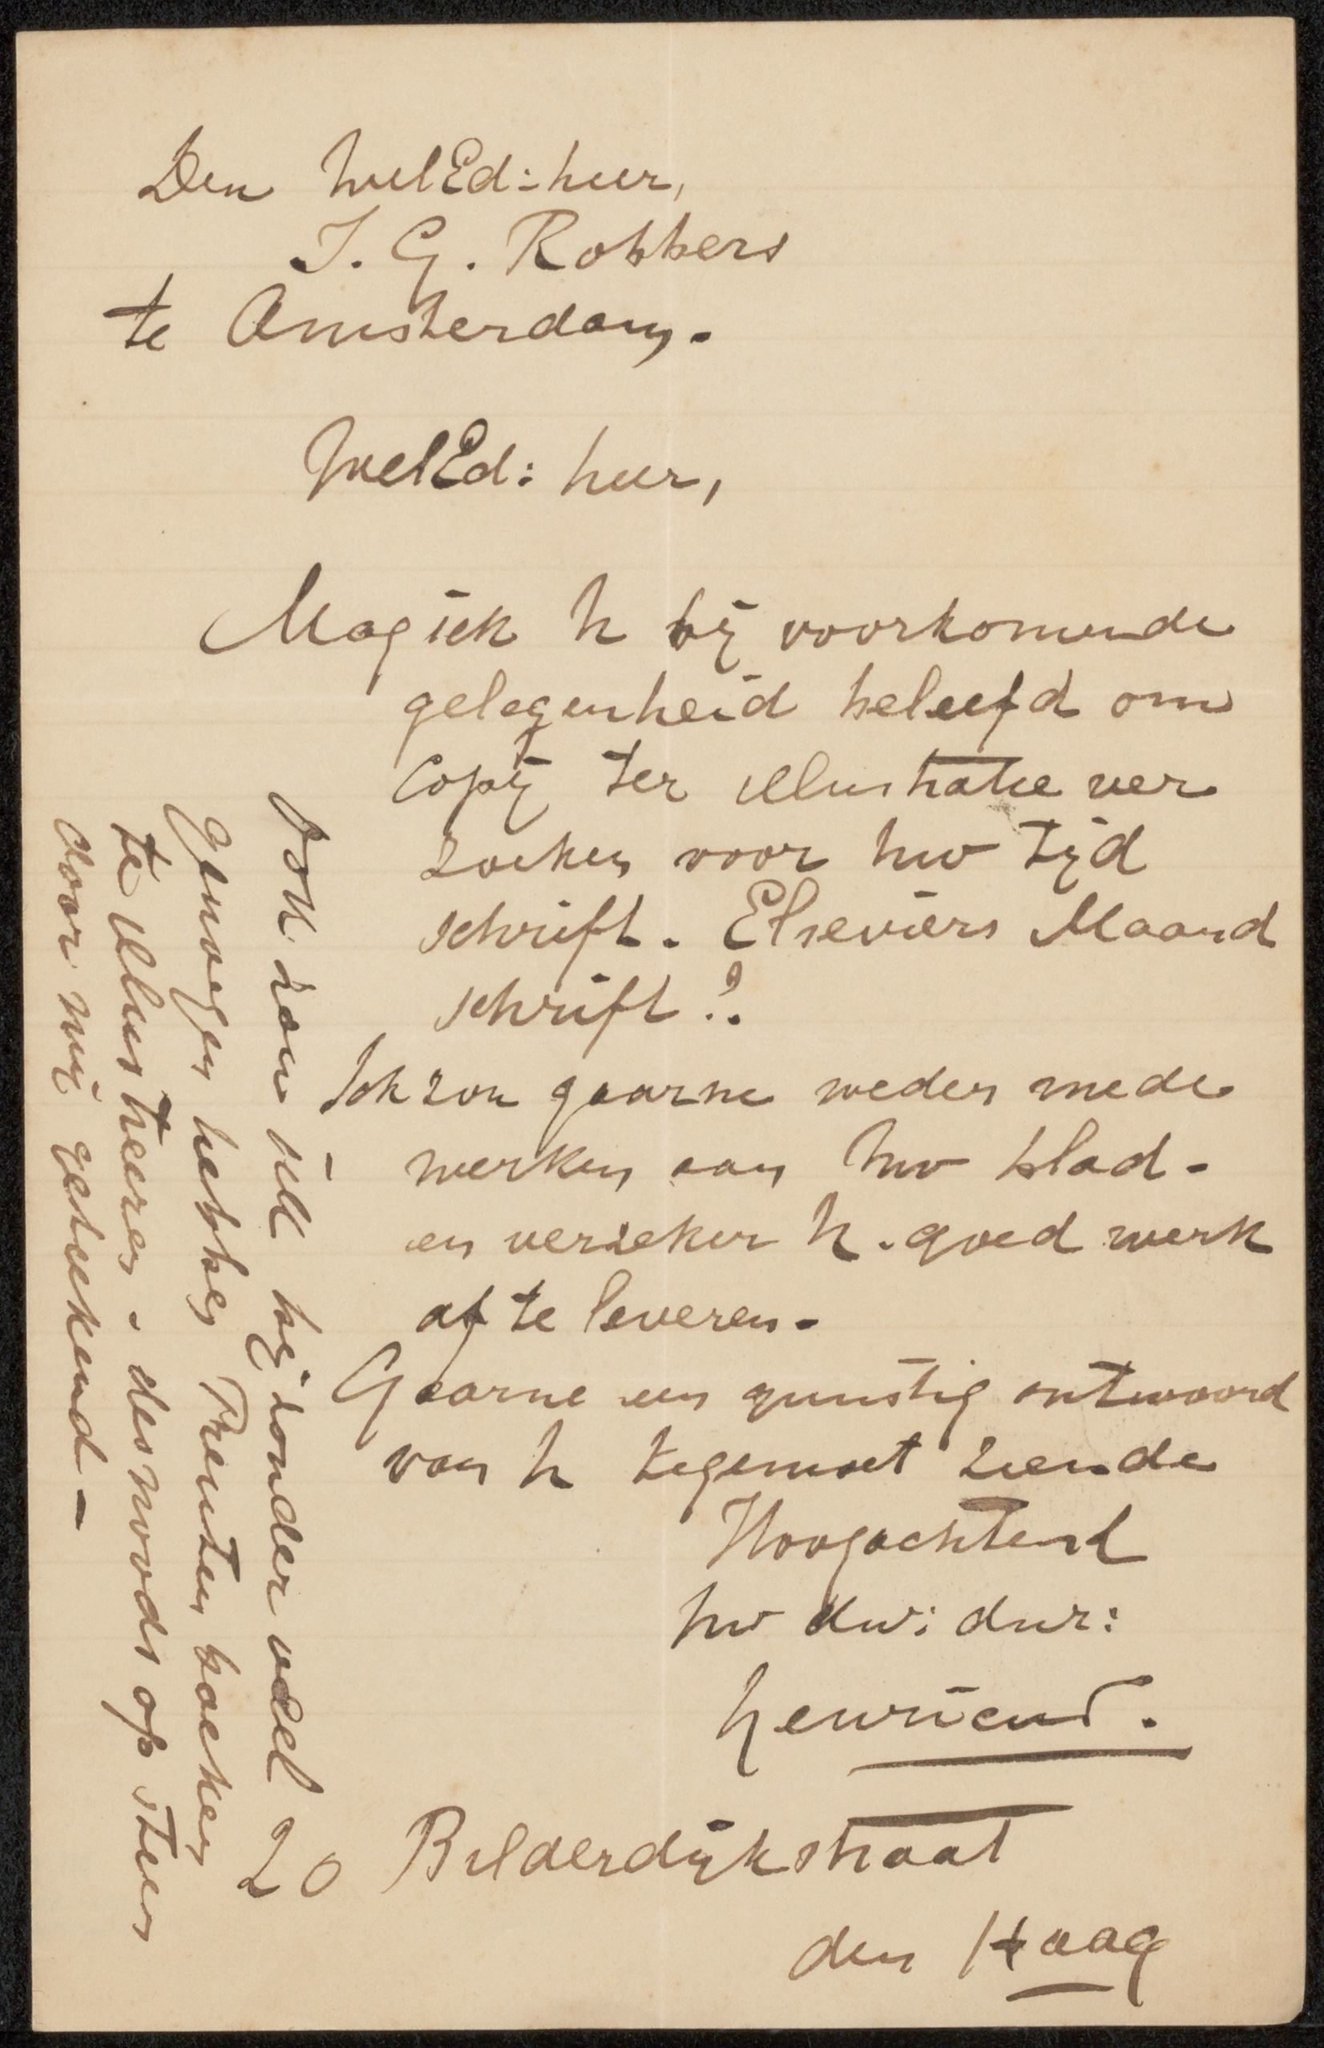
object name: letter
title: Brief aan Jacobus George Robbers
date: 1877-1921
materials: ink, paper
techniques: pen, writing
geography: amsterdam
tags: jacobus george robbers, the graphic arts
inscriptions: collector's mark: ‘RPK’